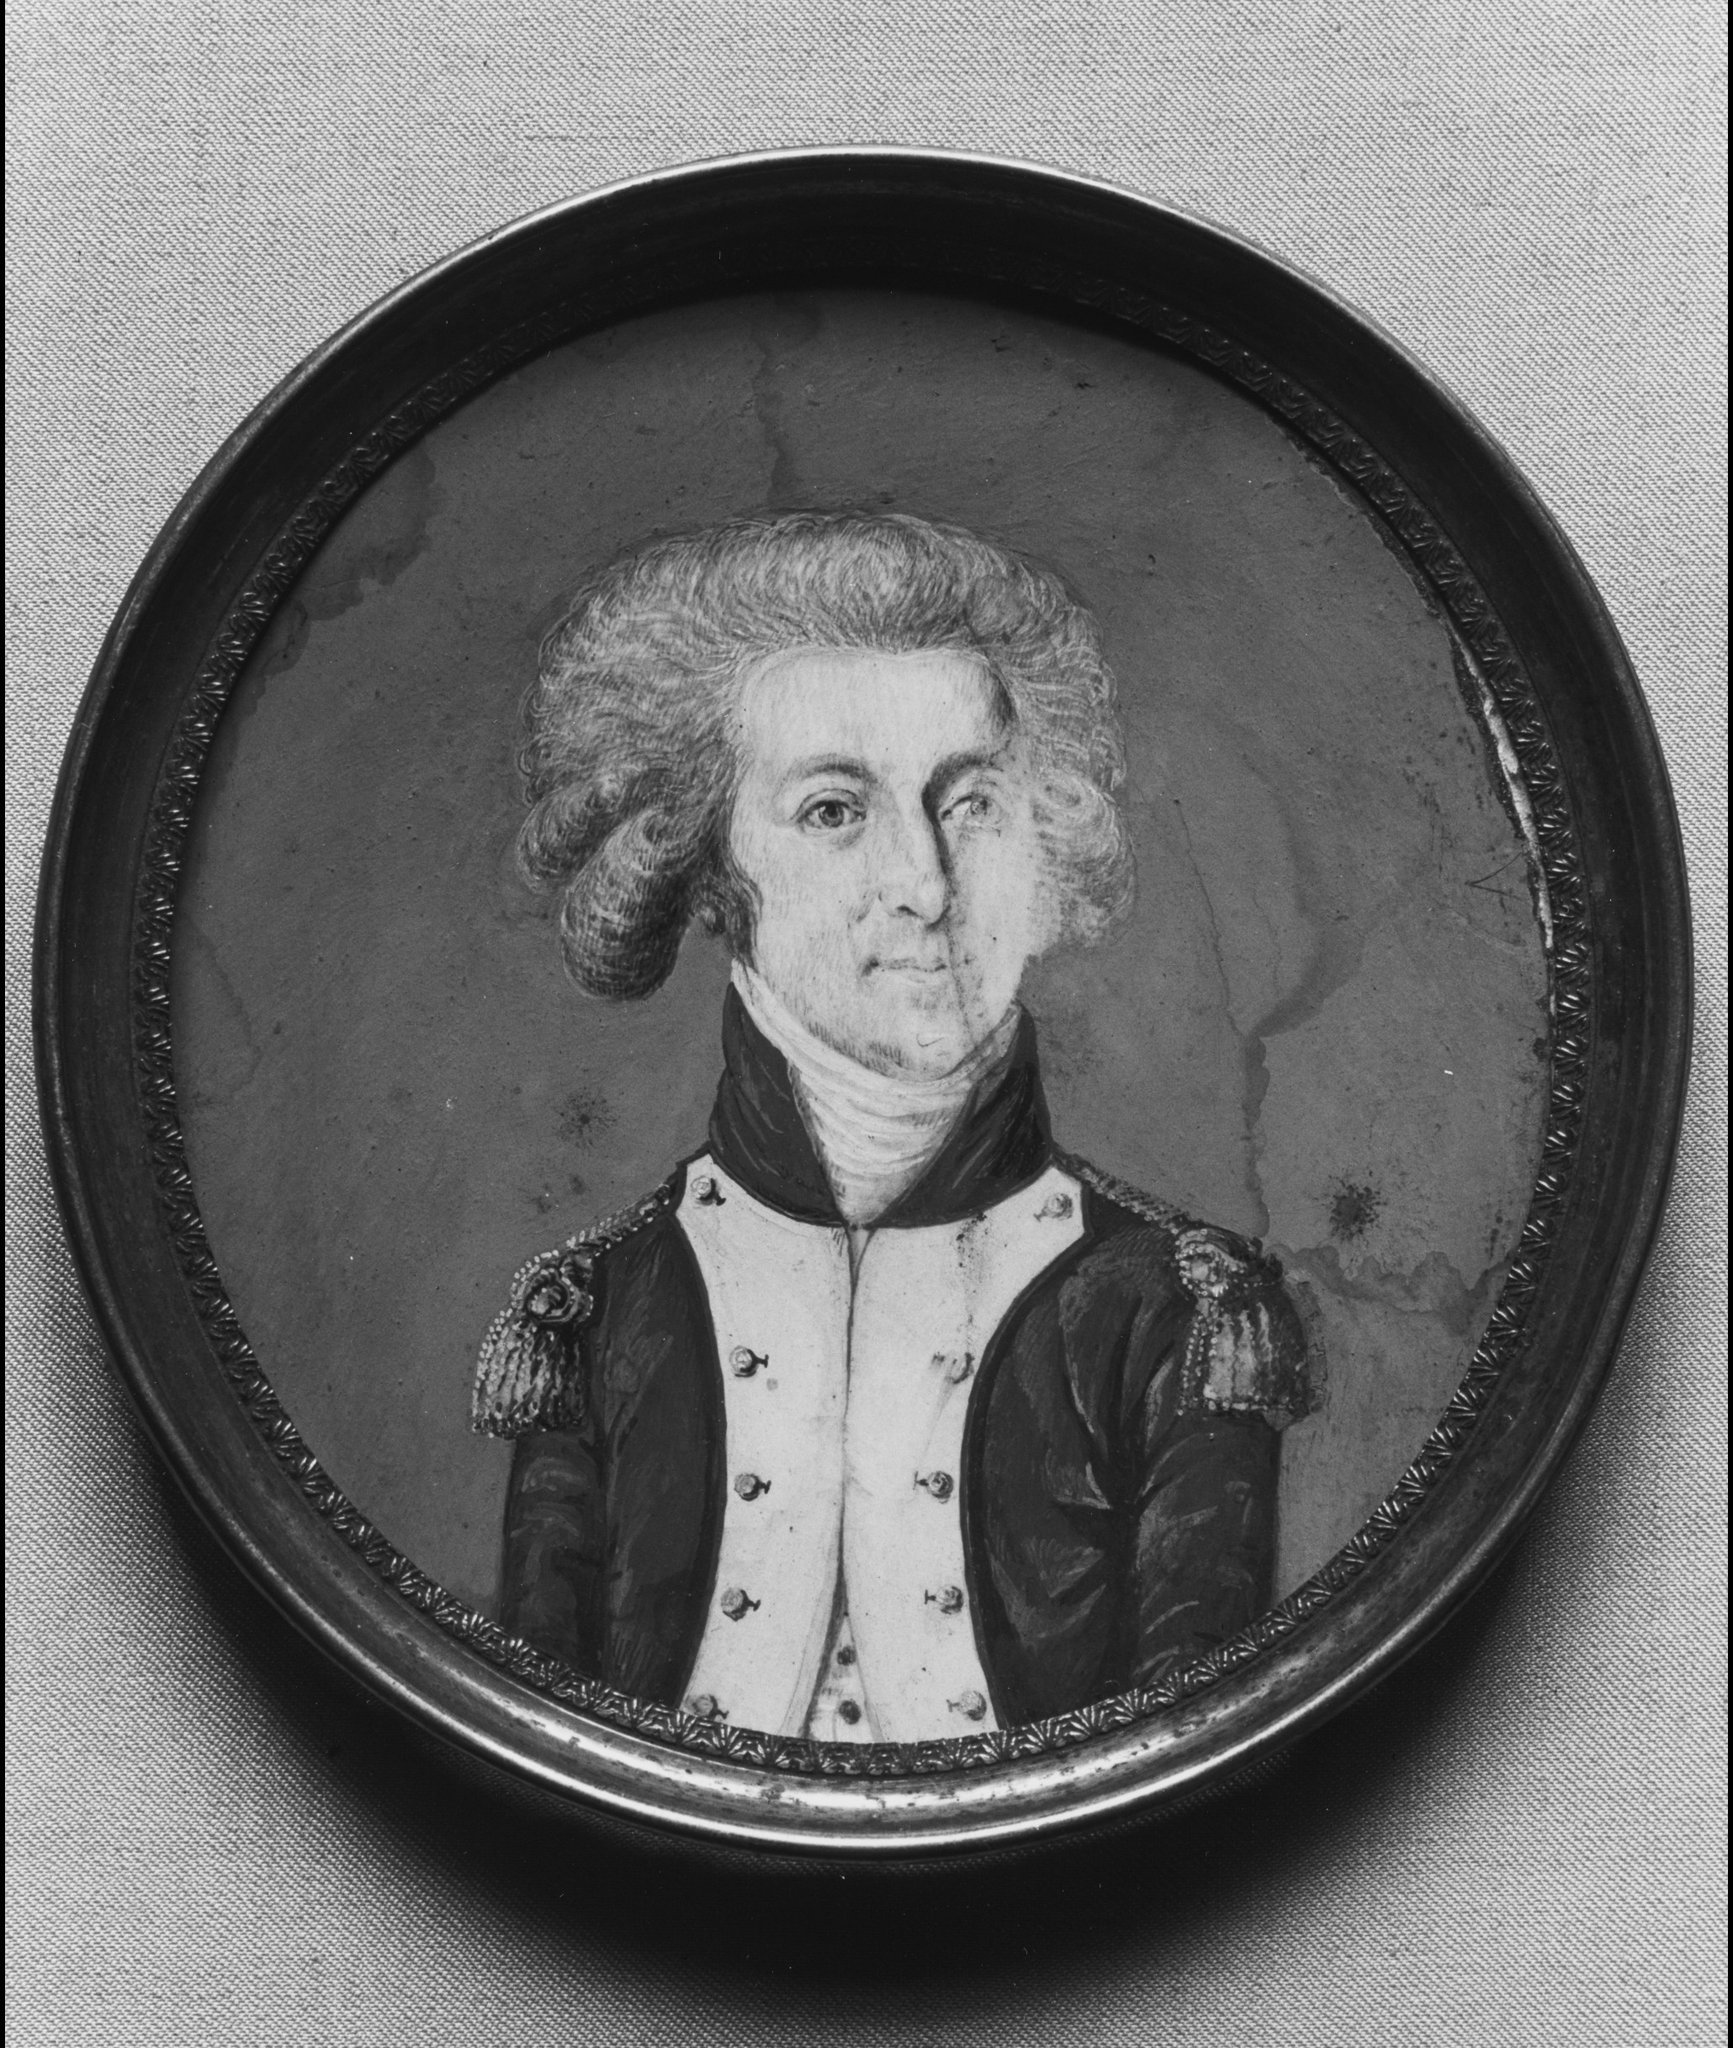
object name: painting, miniature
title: Portrait Miniature of the Marquis de Lafayette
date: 1775-1883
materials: ivory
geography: france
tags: men,portraits,marquis de lafayette